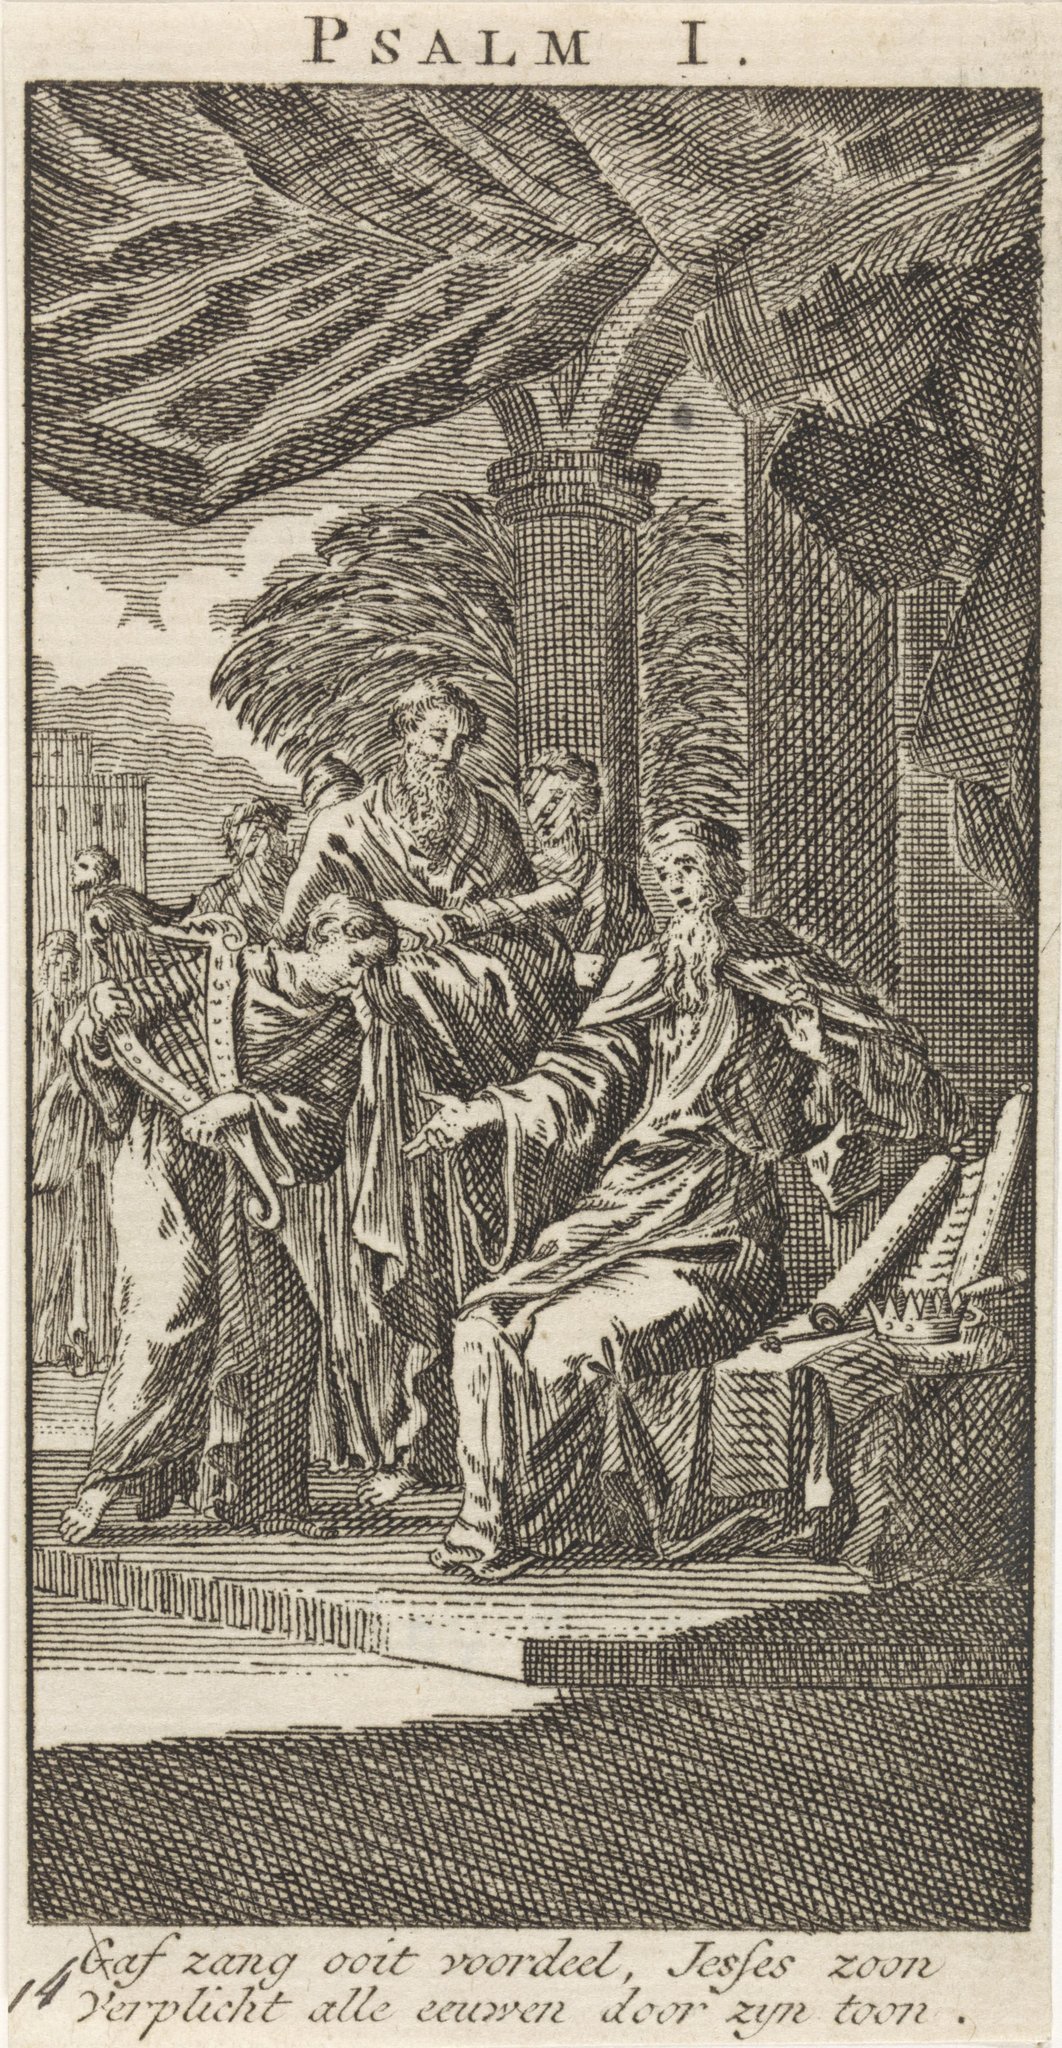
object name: print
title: David wordt zijn harp gebracht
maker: Anonymous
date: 1712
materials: paper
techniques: etching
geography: amsterdam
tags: david as harpist at saul's court (1 samuel 16:14-23)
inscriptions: collector's mark: Lugt 2228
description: Kopie van illustratie voor: Luyken, Jan. Bybel printen. Amsterdam: Pieter Arentsz. II (wed.) en Cornelis van der Sys, 1712, p. 14.